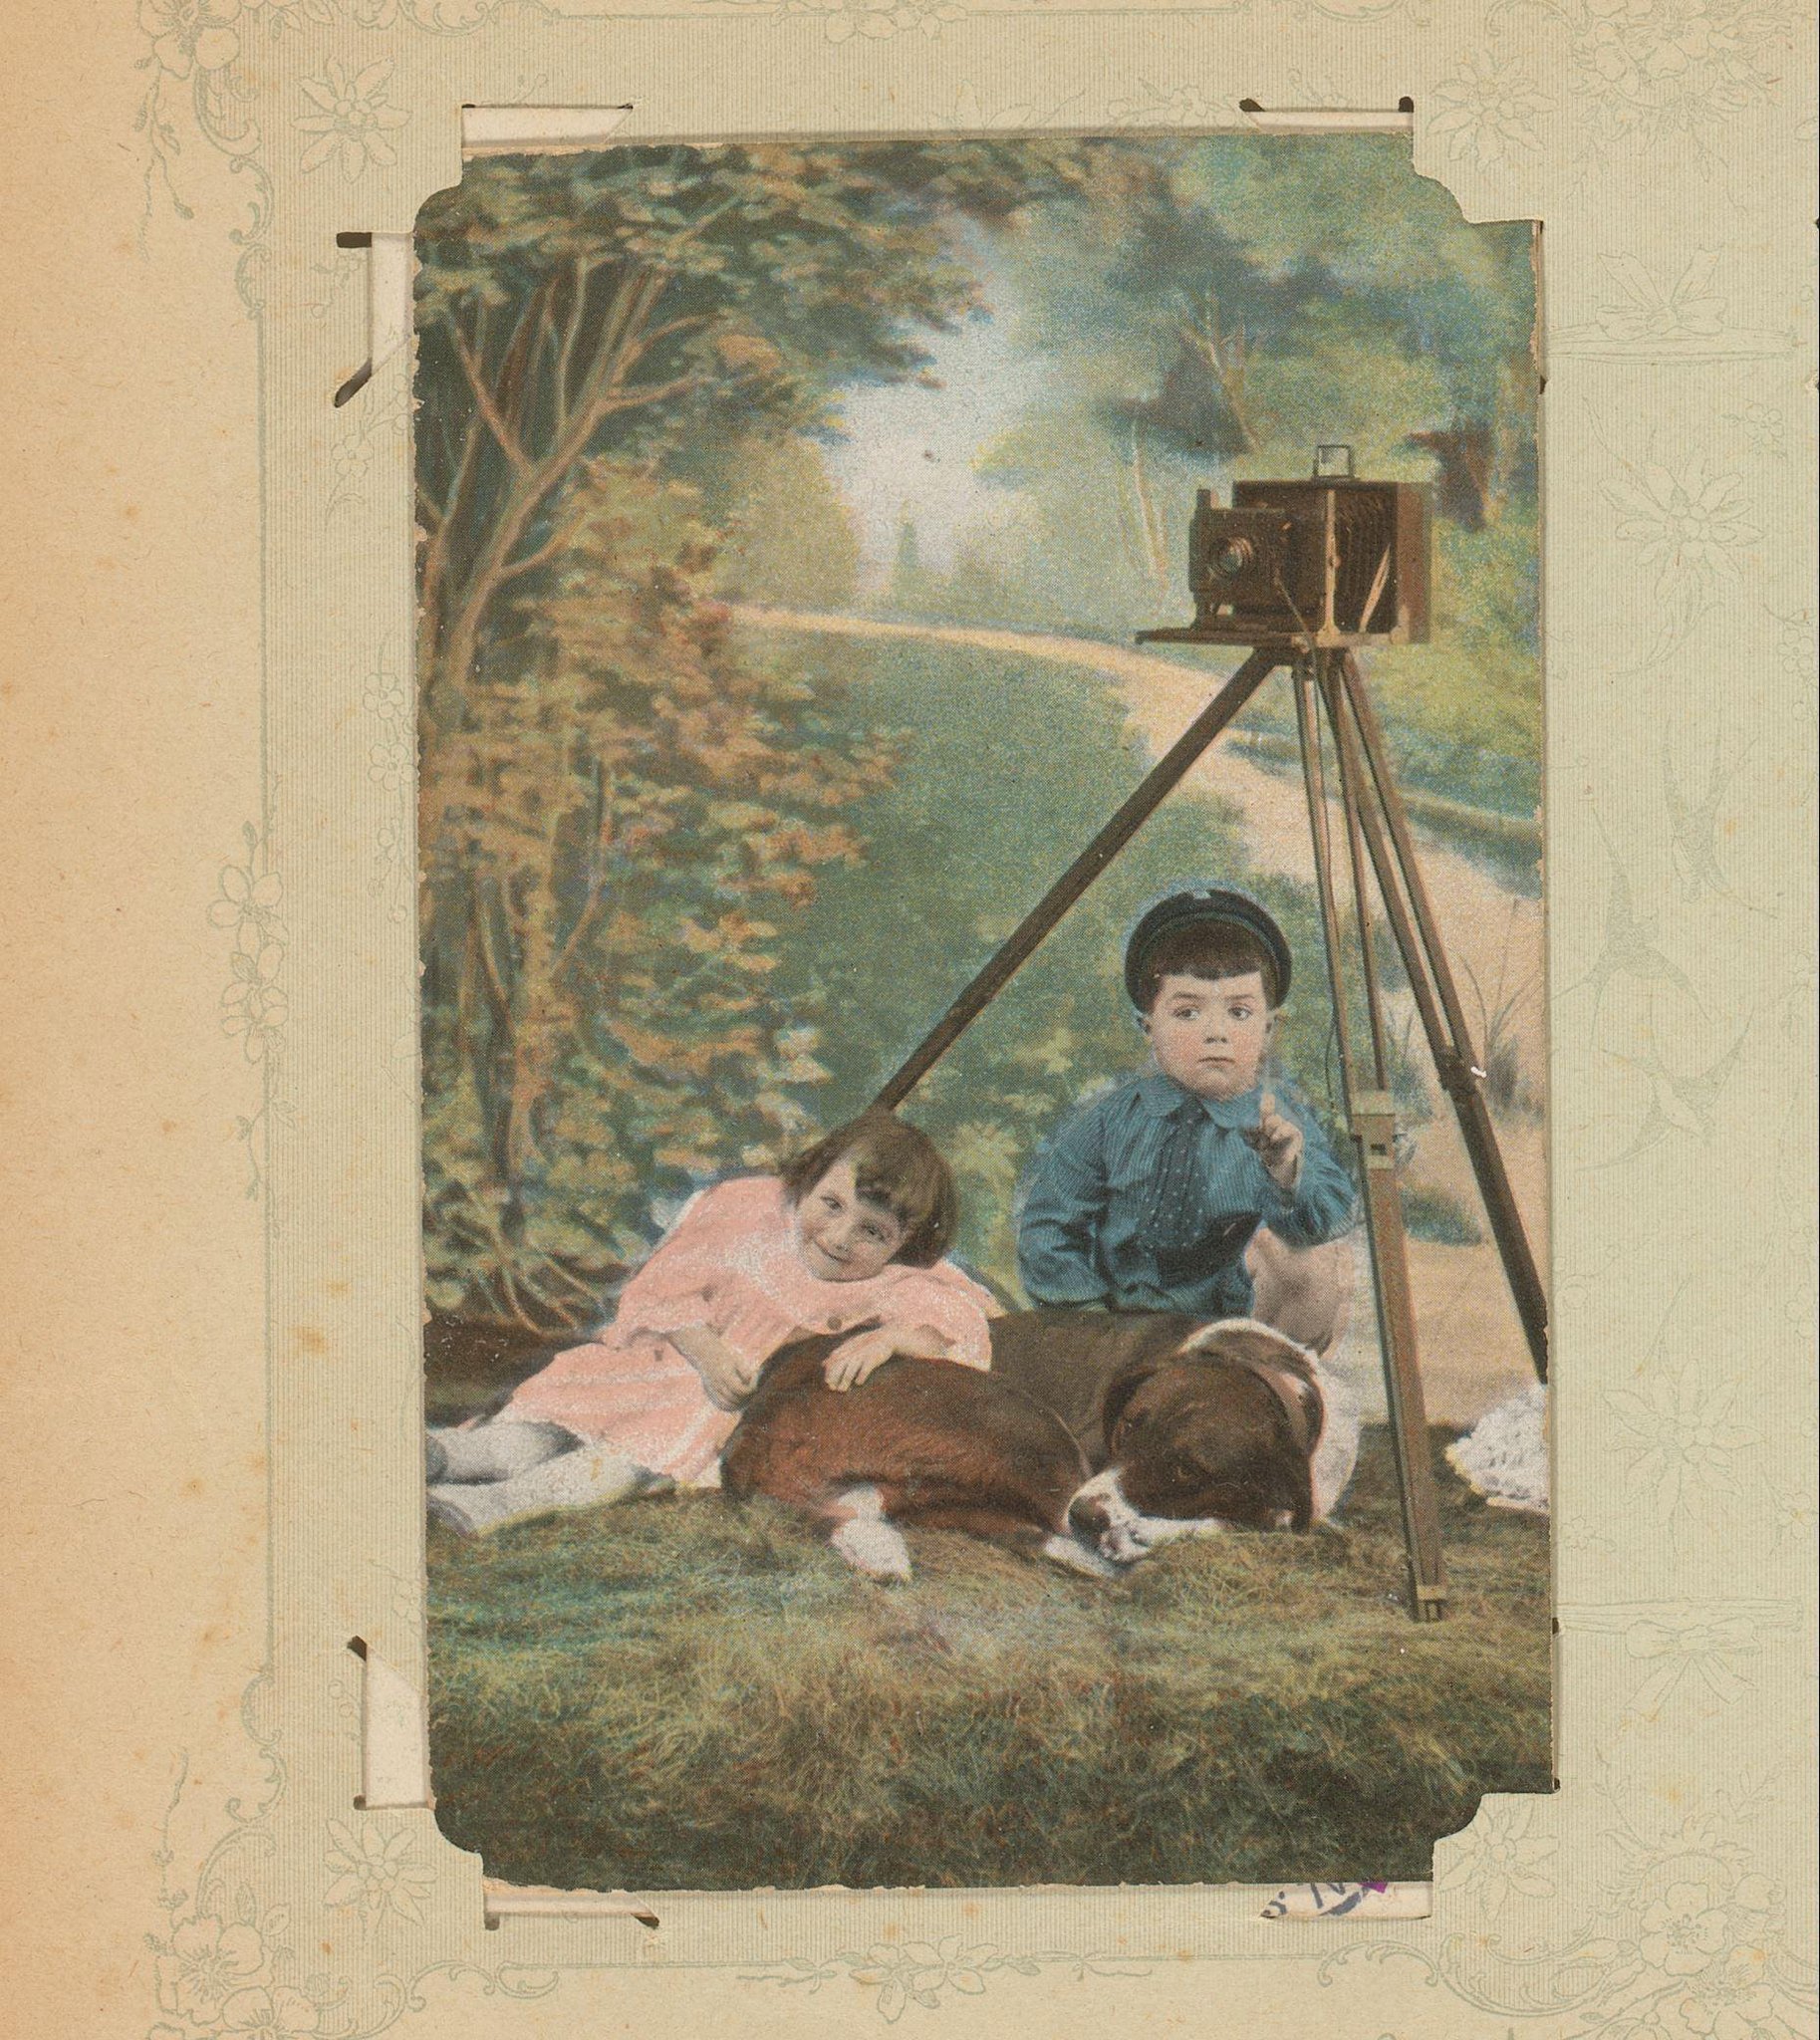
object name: ansichtkaart, prentbriefkaart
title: Vriendelijk kijken alsjeblieft!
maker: Anonymous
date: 1900-1950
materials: cardboard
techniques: four-color autotype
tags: taking photographs, child, (playing with) dolls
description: Deze prent maakt deel uit van een album.